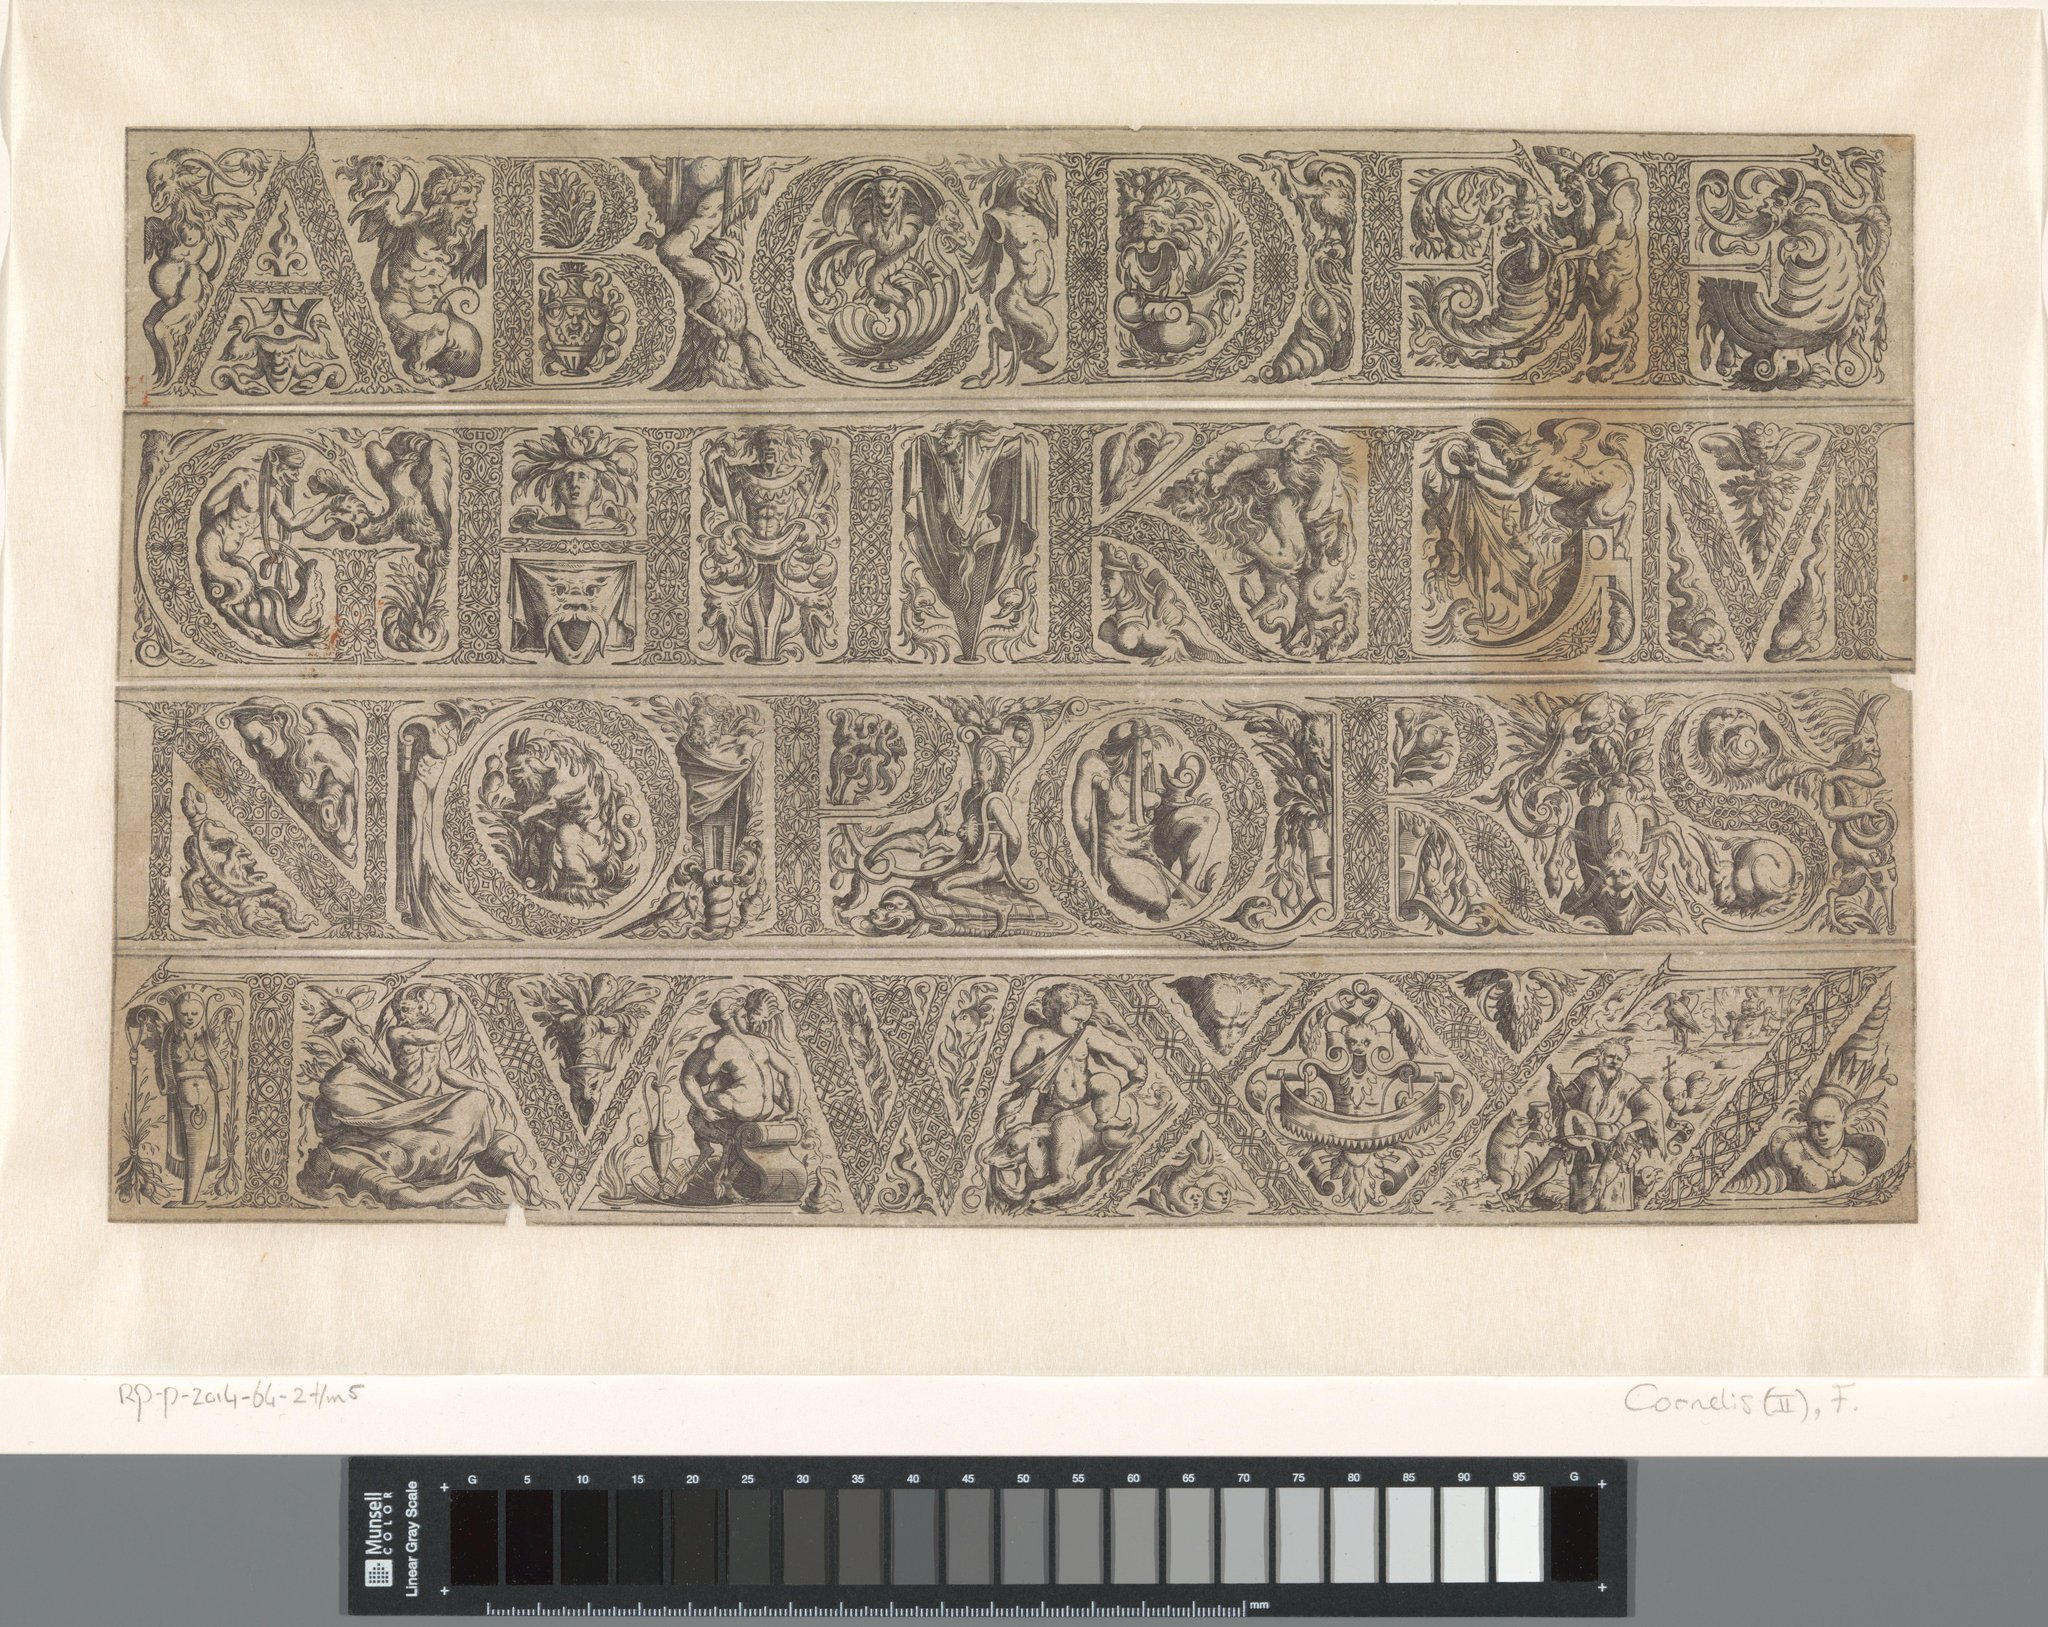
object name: print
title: Fries met de letters N, O, P, Q, R, S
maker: cornelis floris (ii)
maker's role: draughtsman, print maker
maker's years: 1514-1575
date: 1546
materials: paper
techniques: engraving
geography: netherlands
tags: ornaments ~ art, ornament ~ hybrid beings; human and animal forms mixed, letters, alphabet, script, satyr(s) (in general)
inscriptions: collector's mark: Lugt 2760, collector's mark: Lugt 2228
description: Fries met de letters N, O, P, Q, R, S. Het fries maakt deel uit van een alfabet opgebouwd uit ornamenten en groteske figuren. Het hele alfabet is gedrukt van een plaat. De afdruk is lang in tact bewaard. De vier friezen zijn pas later losgesneden, zoals onder meer blijkt uit het doorlopen van vlekken. De vier stroken samen als één blad opgezet.